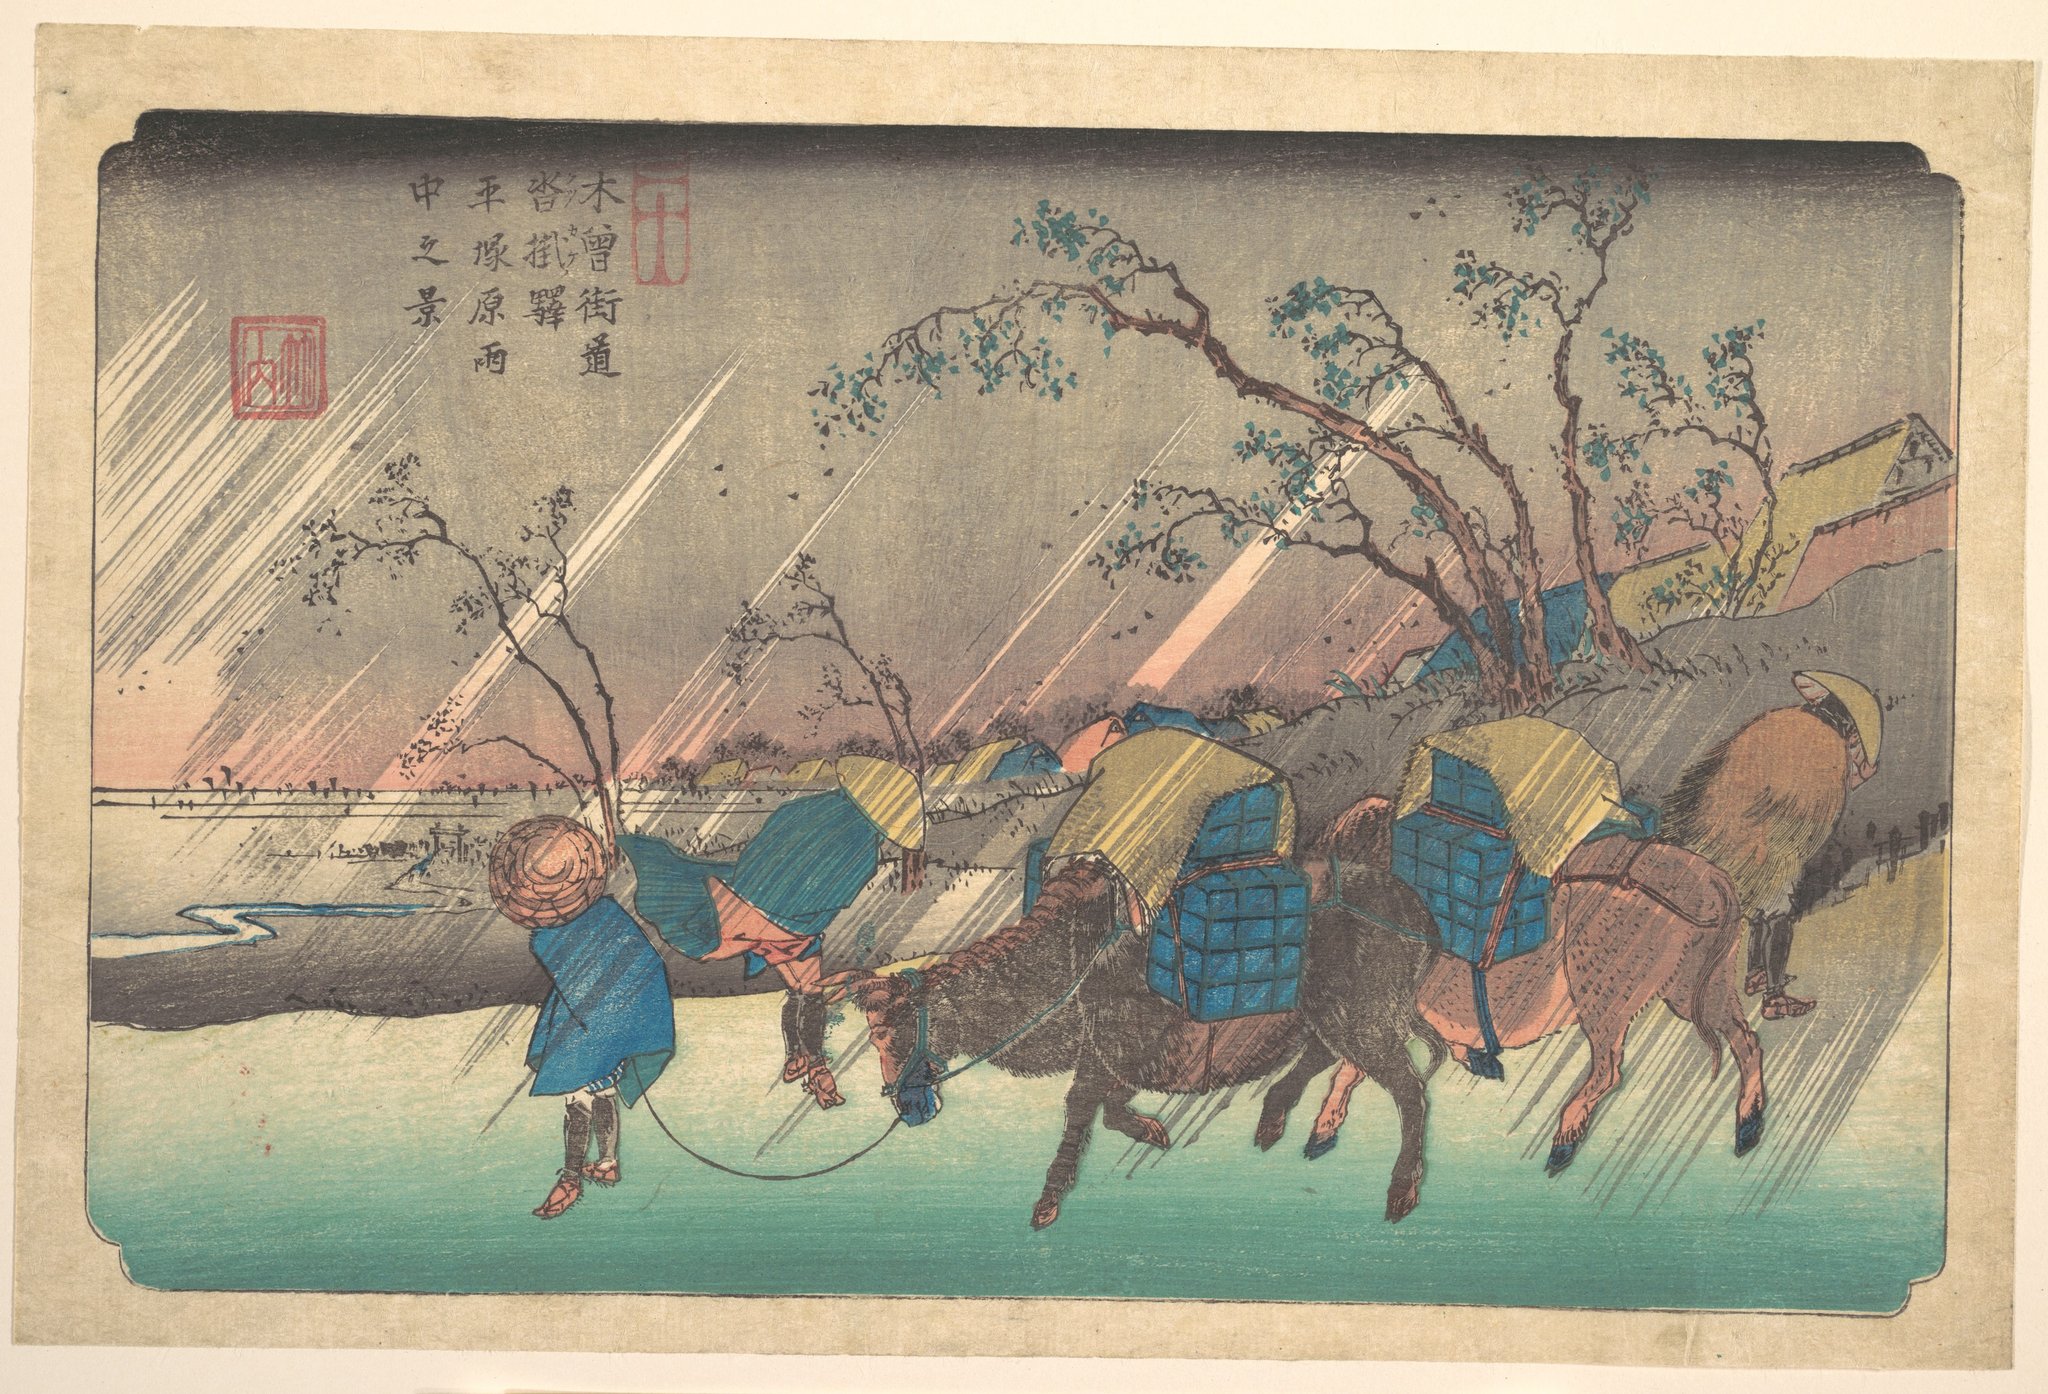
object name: print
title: Hiratsuka near Kutsukake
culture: japanese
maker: keisai eisen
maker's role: artist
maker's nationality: japanese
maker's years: 1790-1848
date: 1790-1848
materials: ink, paper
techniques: woodblock print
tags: human figures,horses,trees,wind